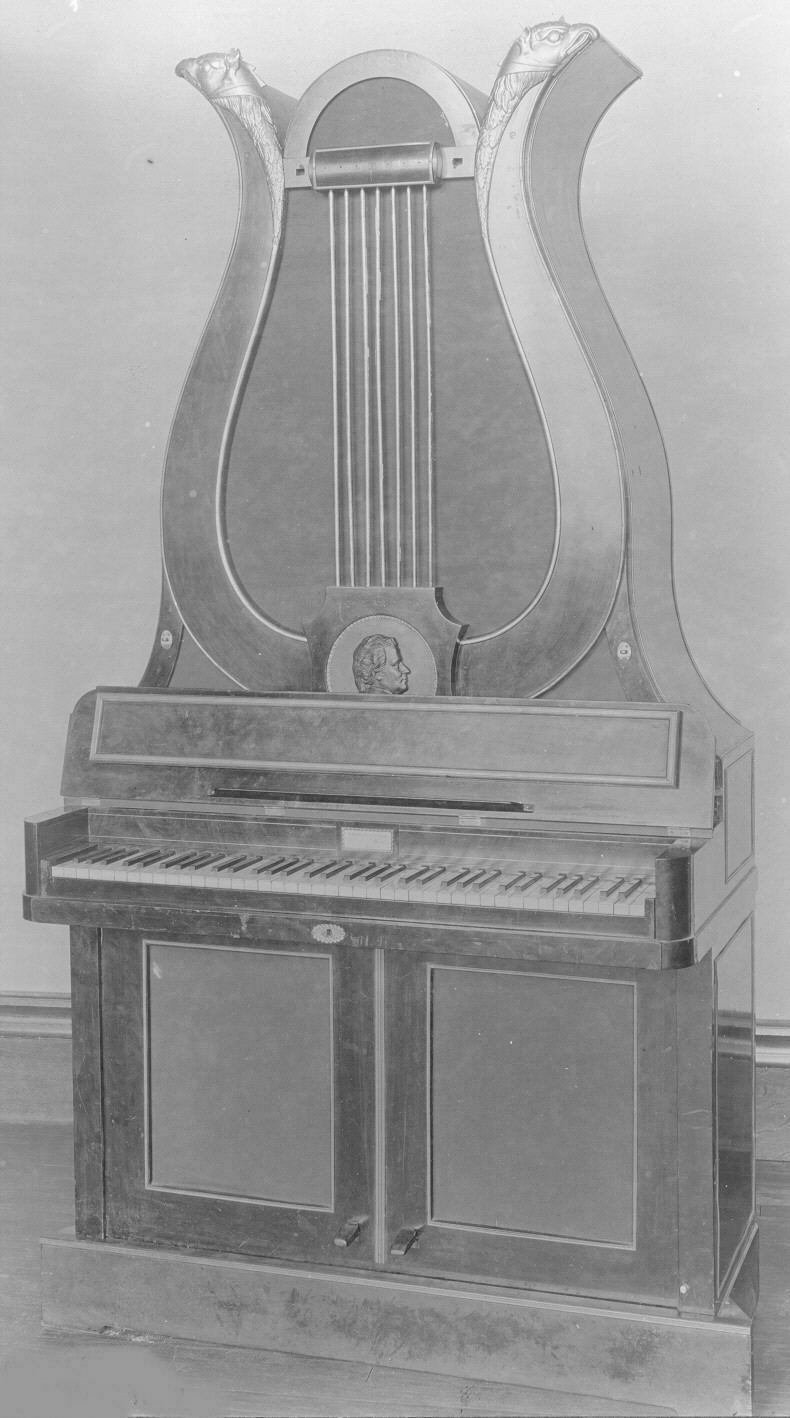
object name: lyraflügel with pedalboard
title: Upright (Lyre) Piano with Pedalboard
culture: german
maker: johann christian schleip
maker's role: maker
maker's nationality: german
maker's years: 1786-1846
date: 1820-1844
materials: wood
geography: germany